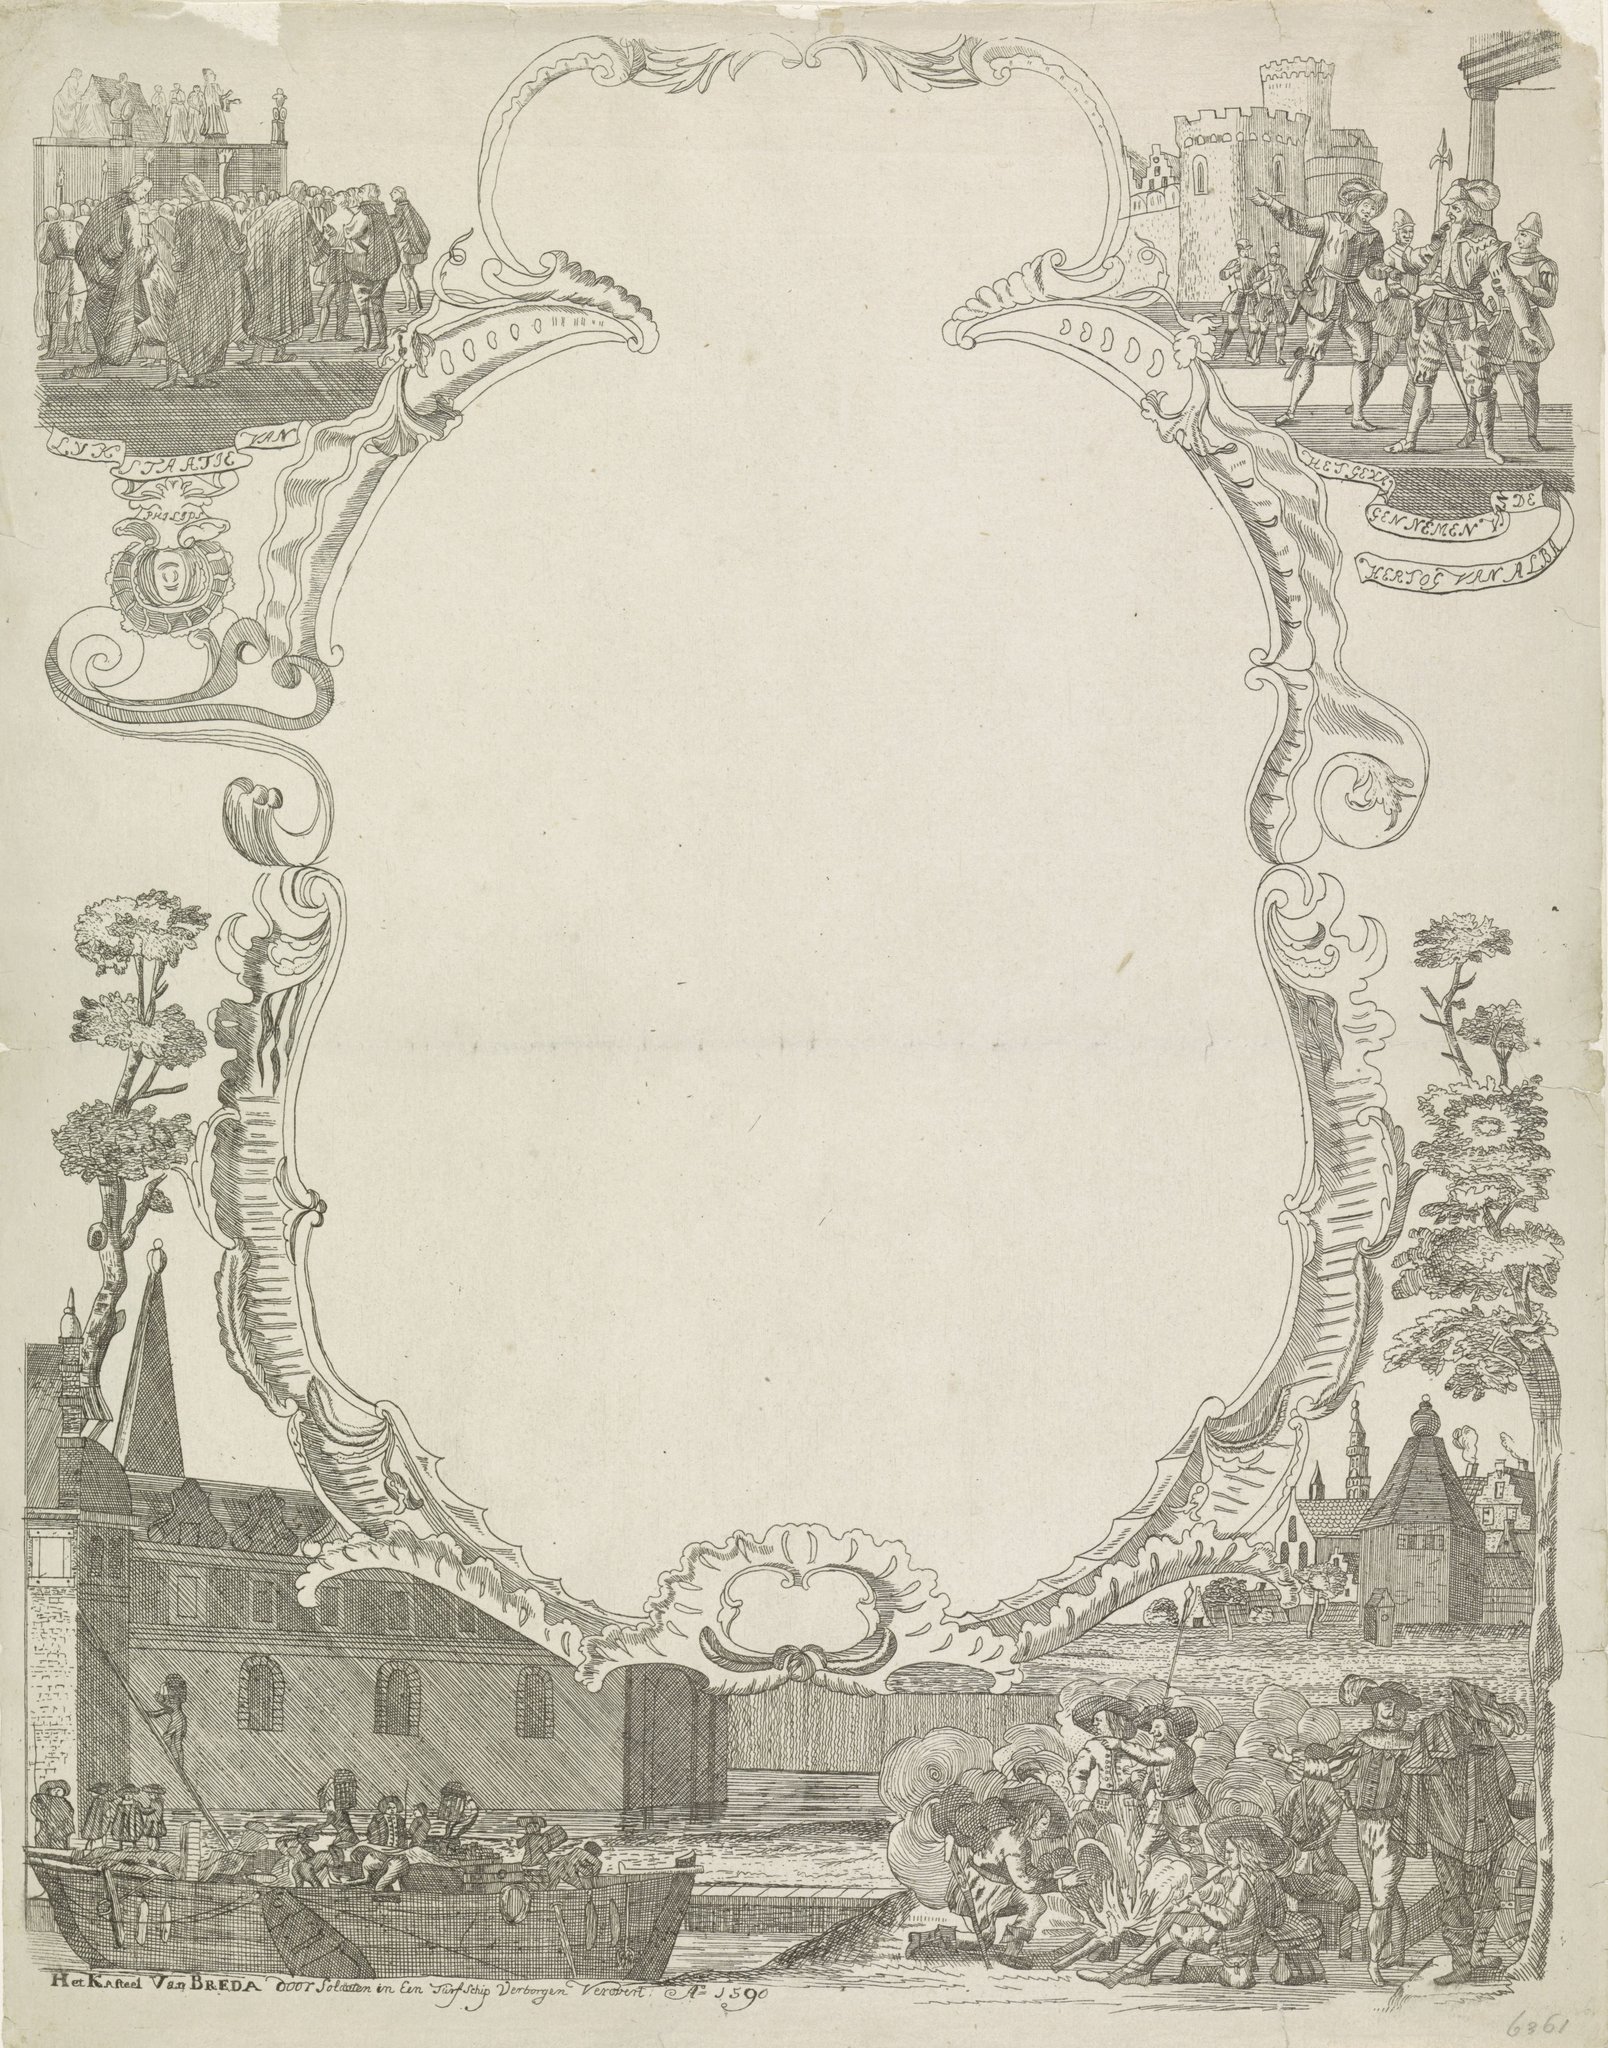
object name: wensbrief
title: Onbeschreven wensbrief, ca. 1830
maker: Anonymous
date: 1825-1835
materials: paper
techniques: etching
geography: netherlands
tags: philip ii of spain, fernando álvarez de toledo (3rd duke of alba)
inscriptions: collector's mark: Lugt 2228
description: Wensbrief uit ca. 1830 met een onbeschreven cartouche. binnen een kader opgebouwd uit drie historische gebeurtenissen. Boven de gevangenname van de hertog van Alva en lijkstatie van koning Filips II, onderaan het turfschip van Breda.